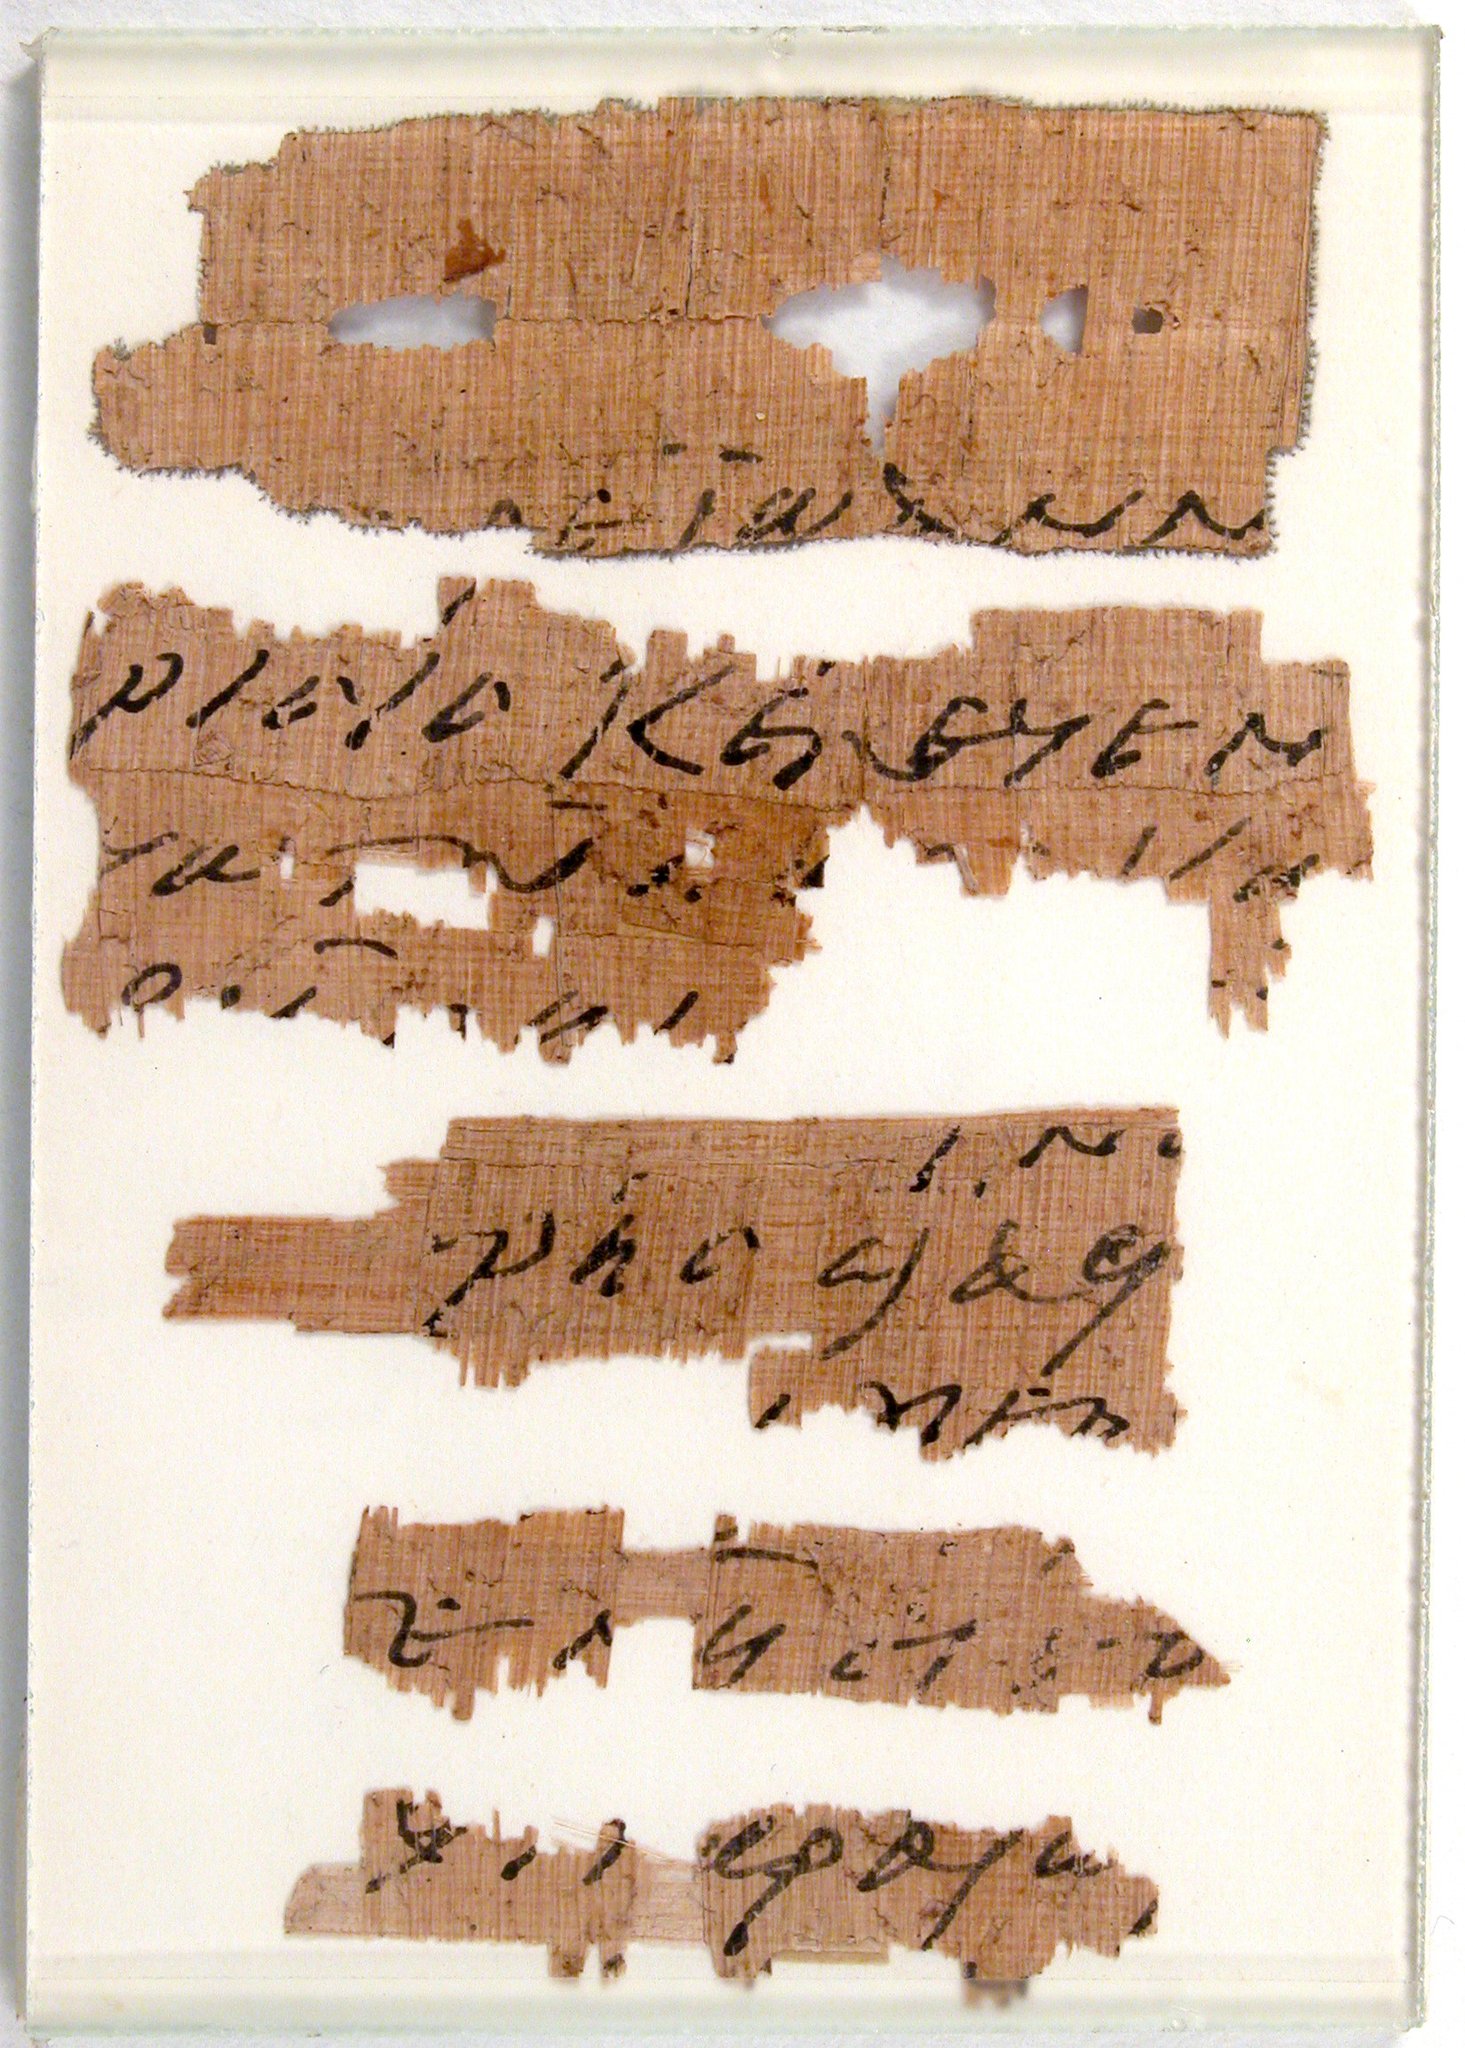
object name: fragment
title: Papyri Fragments of a Letter to Epiphanius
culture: coptic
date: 601-700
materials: ink, papyrus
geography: egypt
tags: coptic